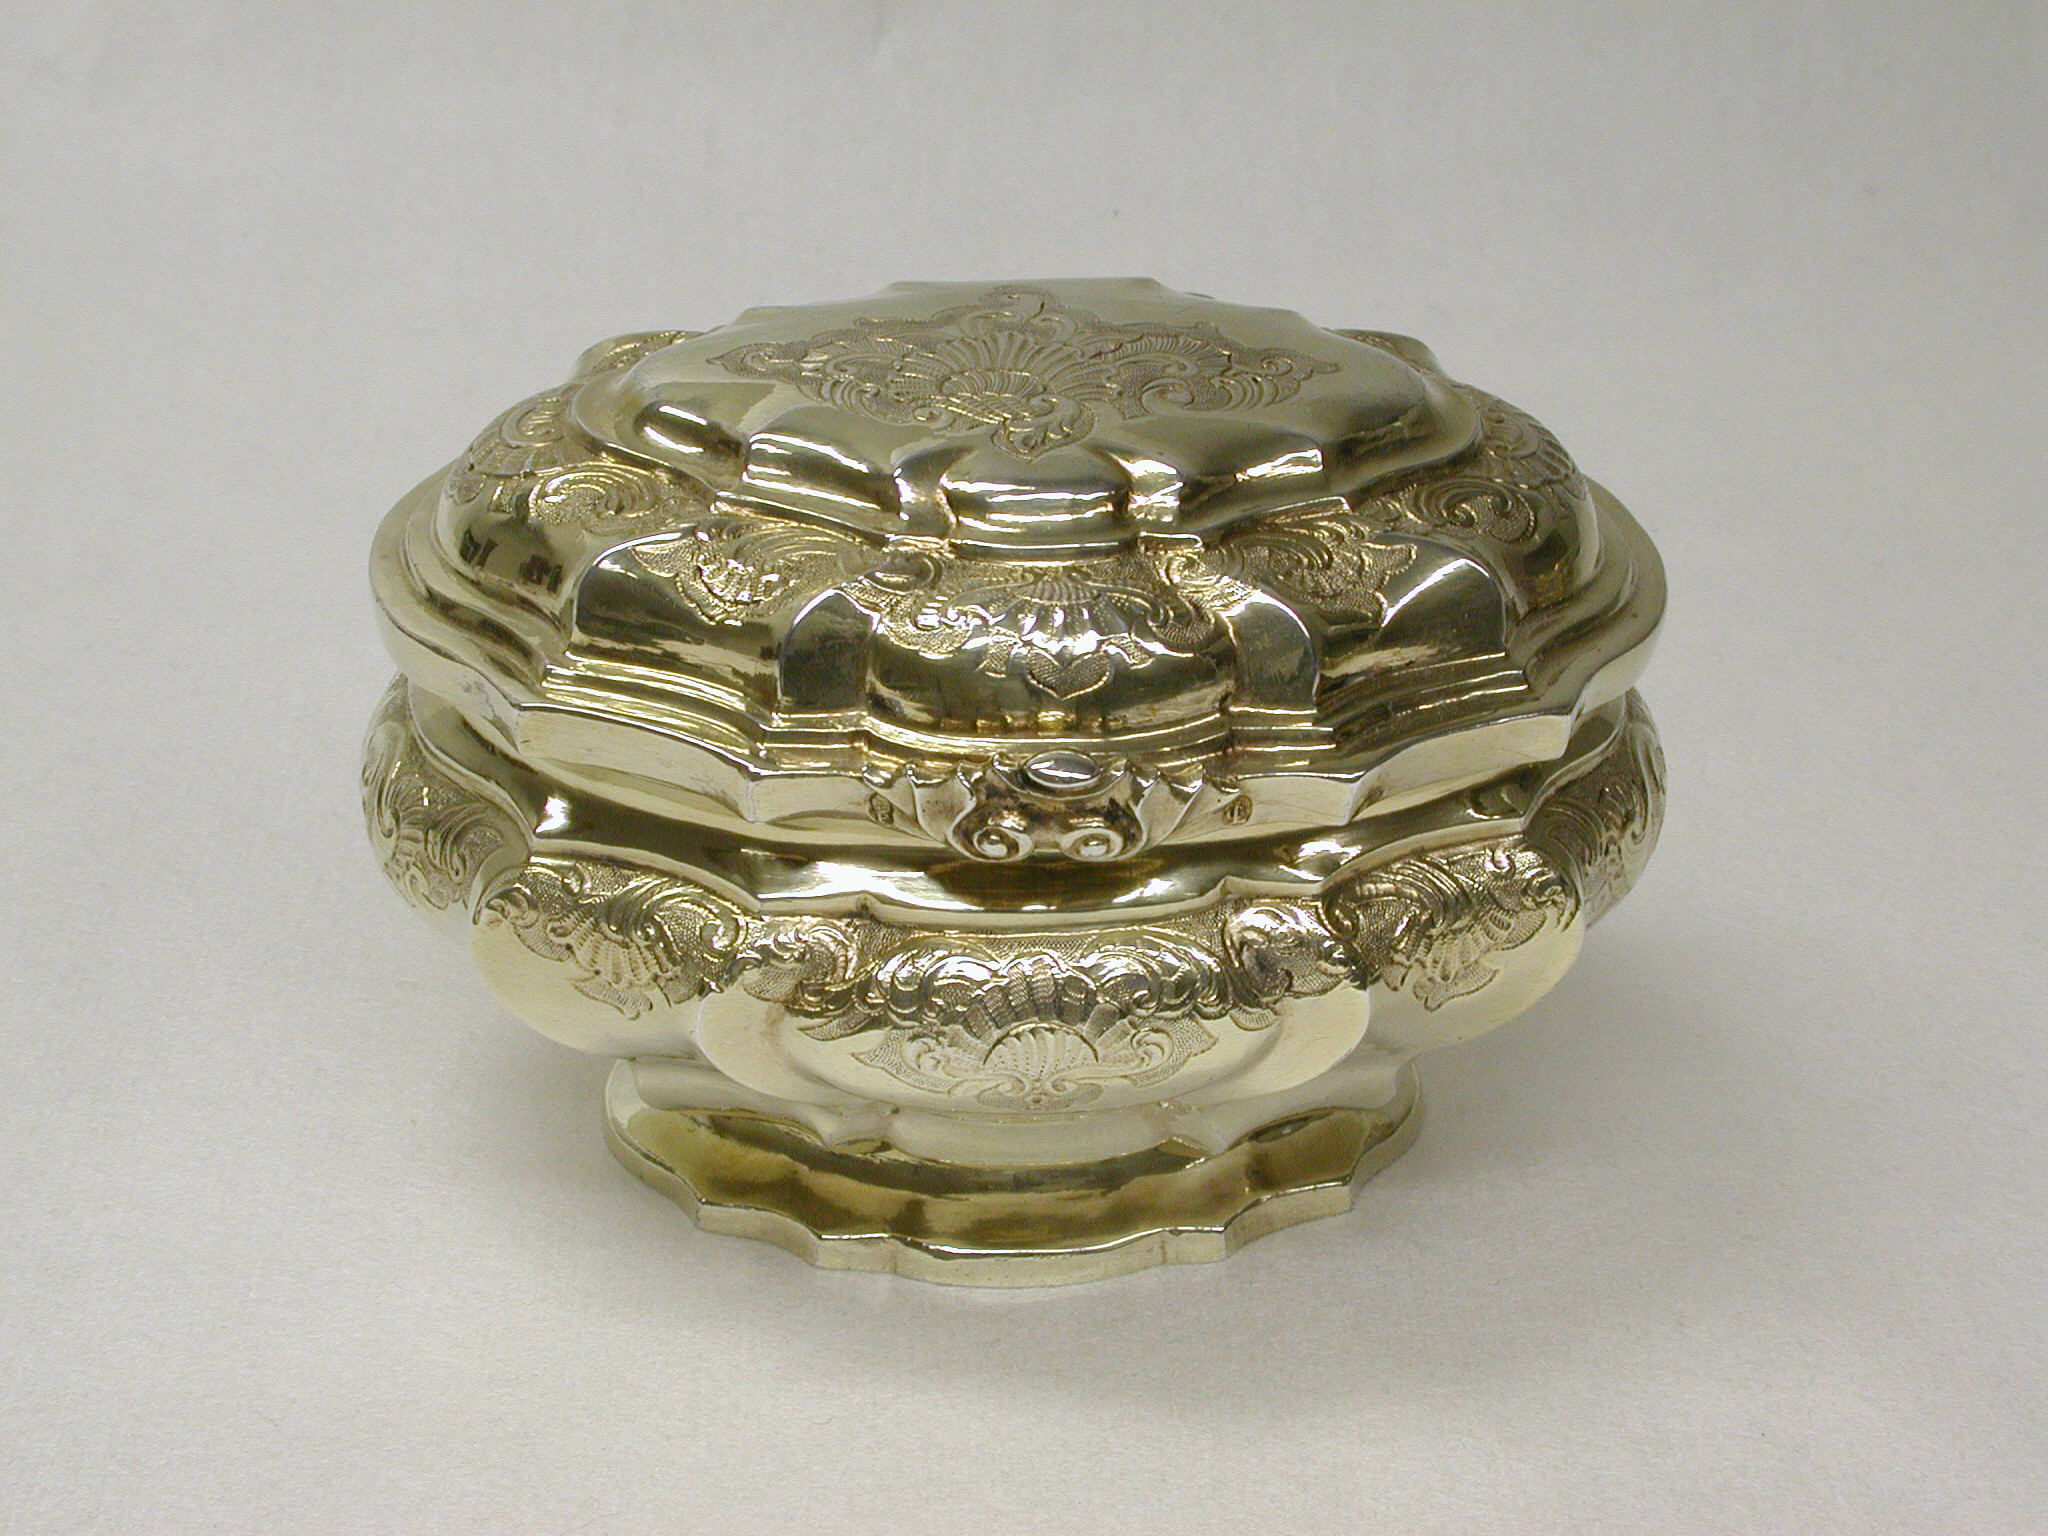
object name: toilet box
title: Toilet box (one of a pair)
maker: johann conrad lotter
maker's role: maker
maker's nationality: german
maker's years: 1738-1779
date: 1743-1745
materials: silver gilt